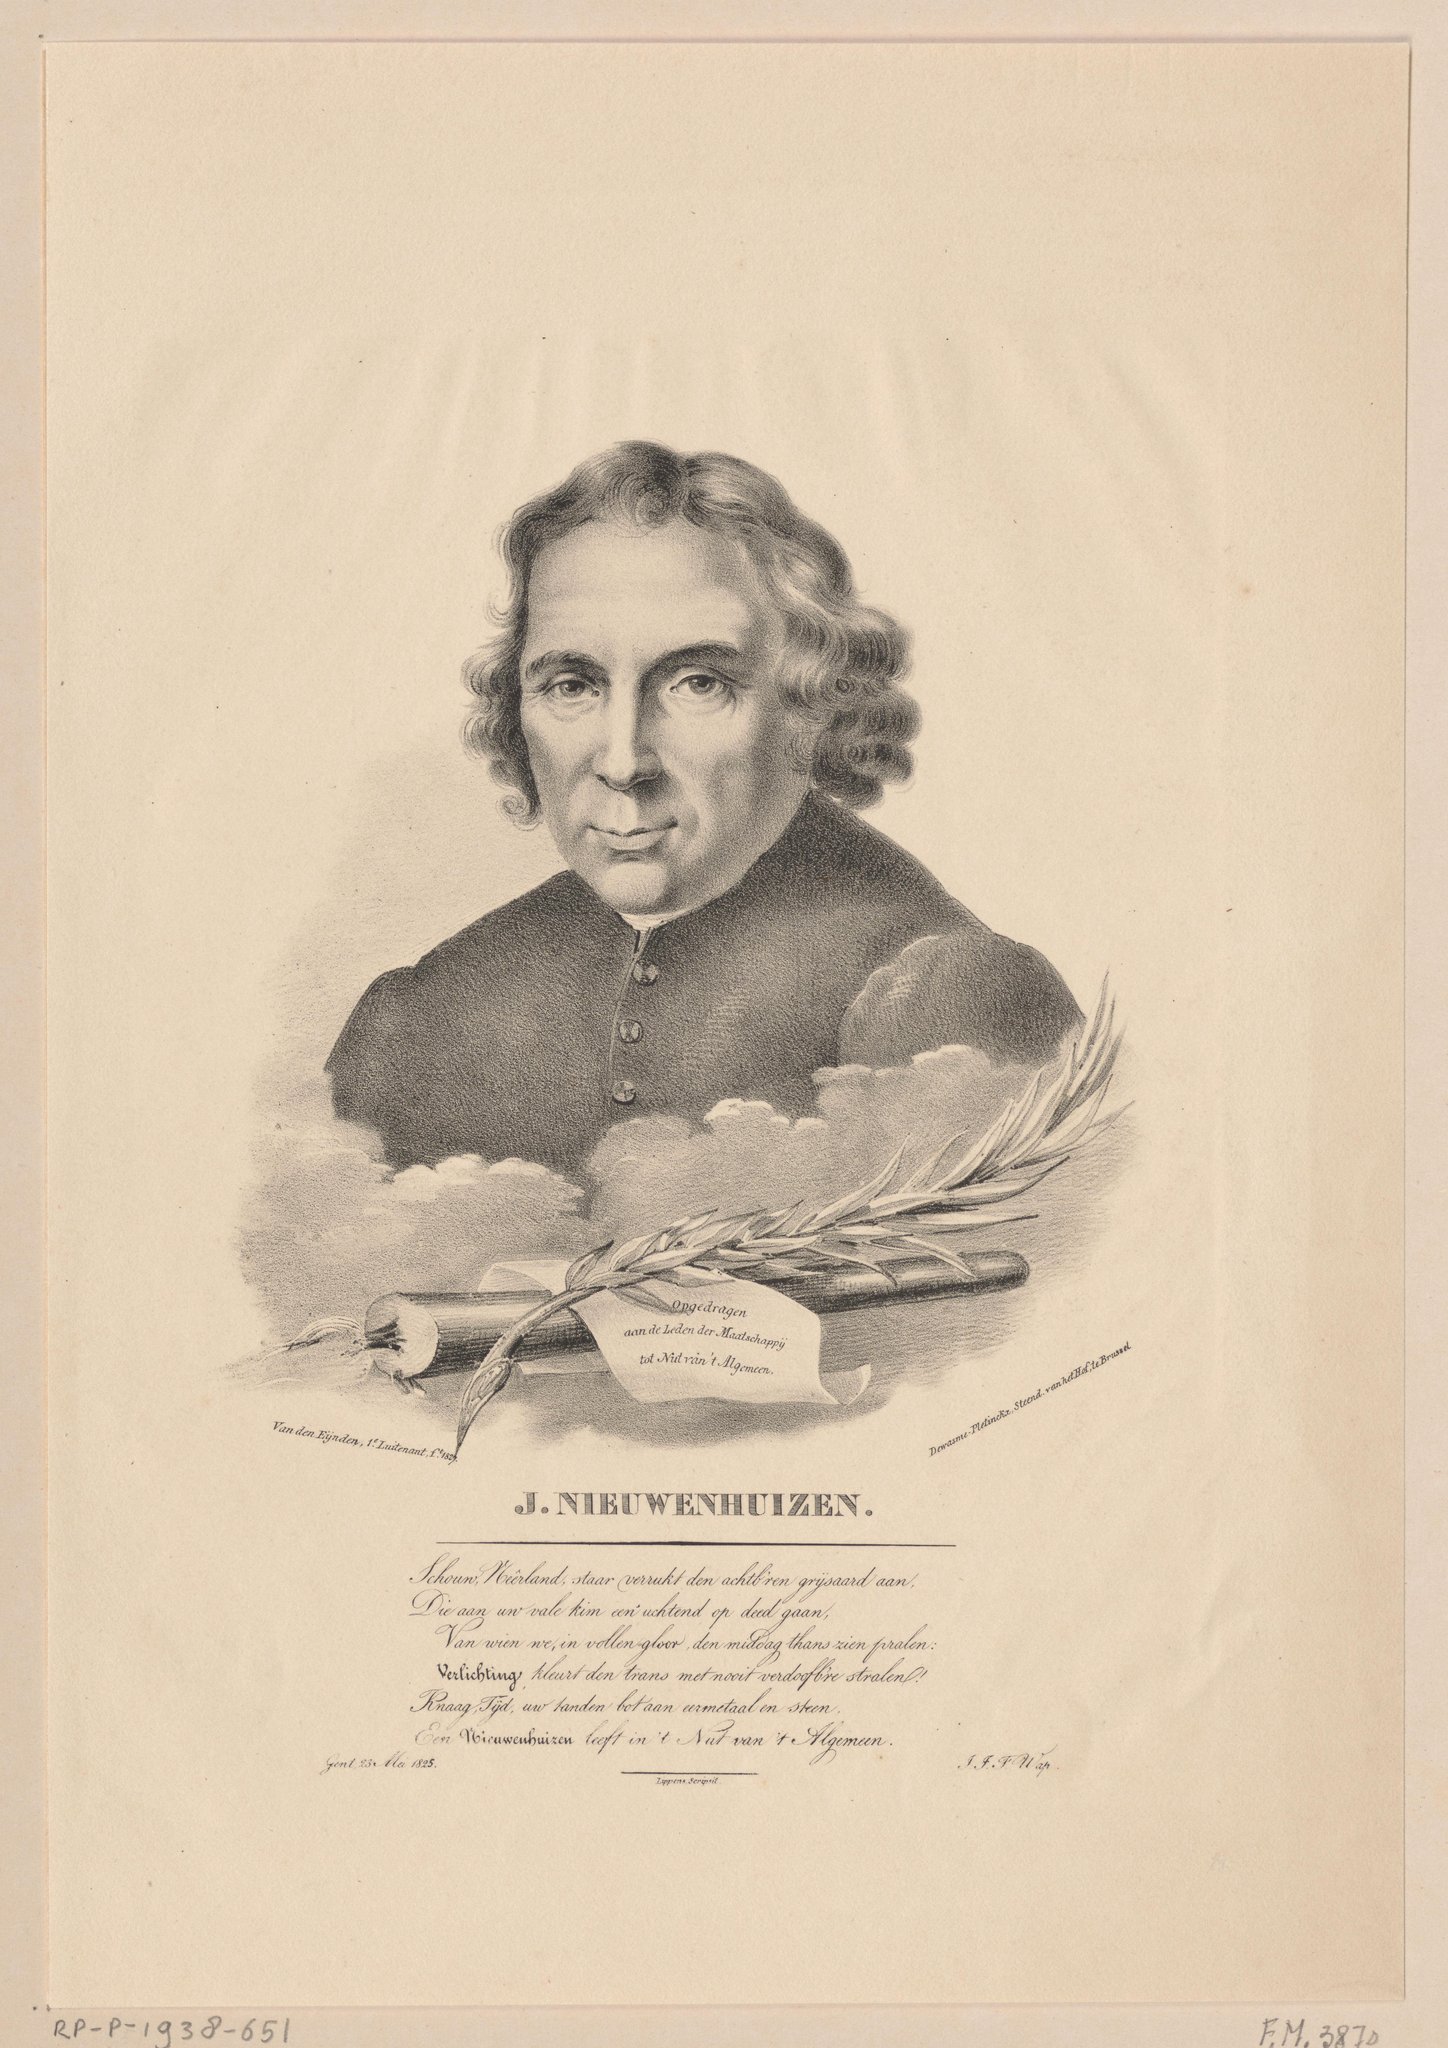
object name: print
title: Portret van Jan Nieuwenhuyzen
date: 1827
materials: paper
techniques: lithograph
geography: brussels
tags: haarlem, amsterdam, jan nieuwenhuyzen, historical persons, candle, functionaries and dignitaries ~ protestant churches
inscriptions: collector's mark: Lugt 2228